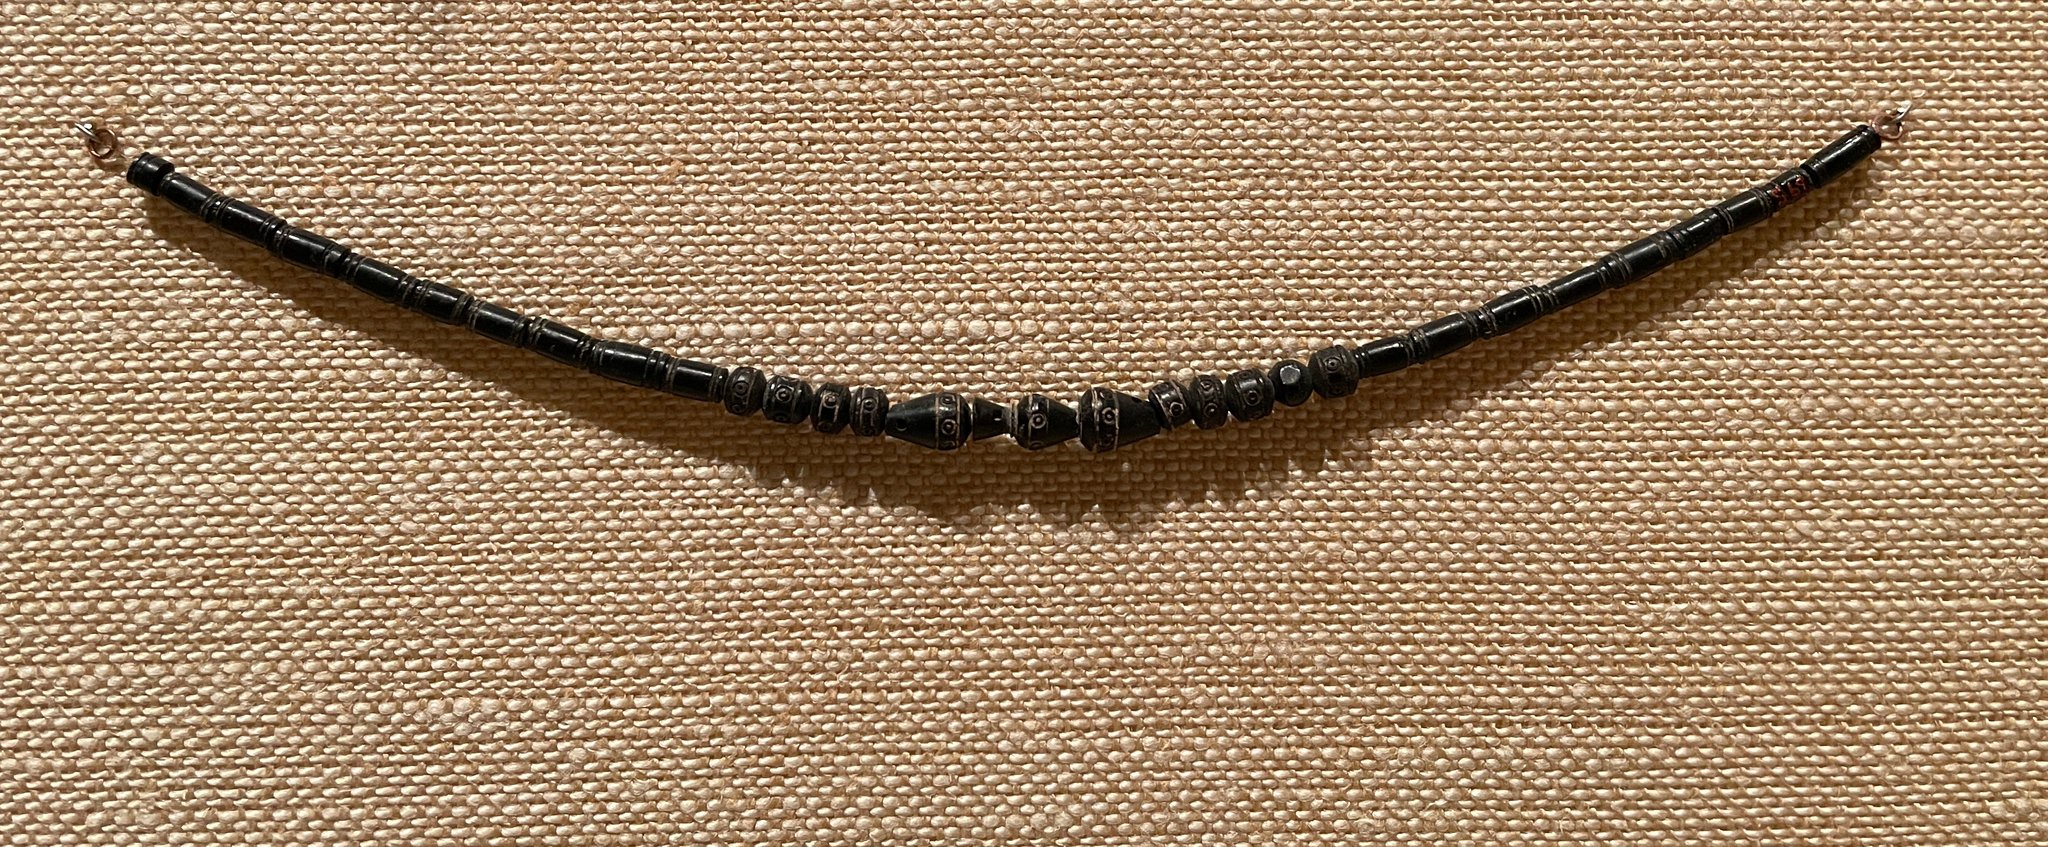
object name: bead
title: String of Beads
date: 701-1200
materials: stone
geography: iran